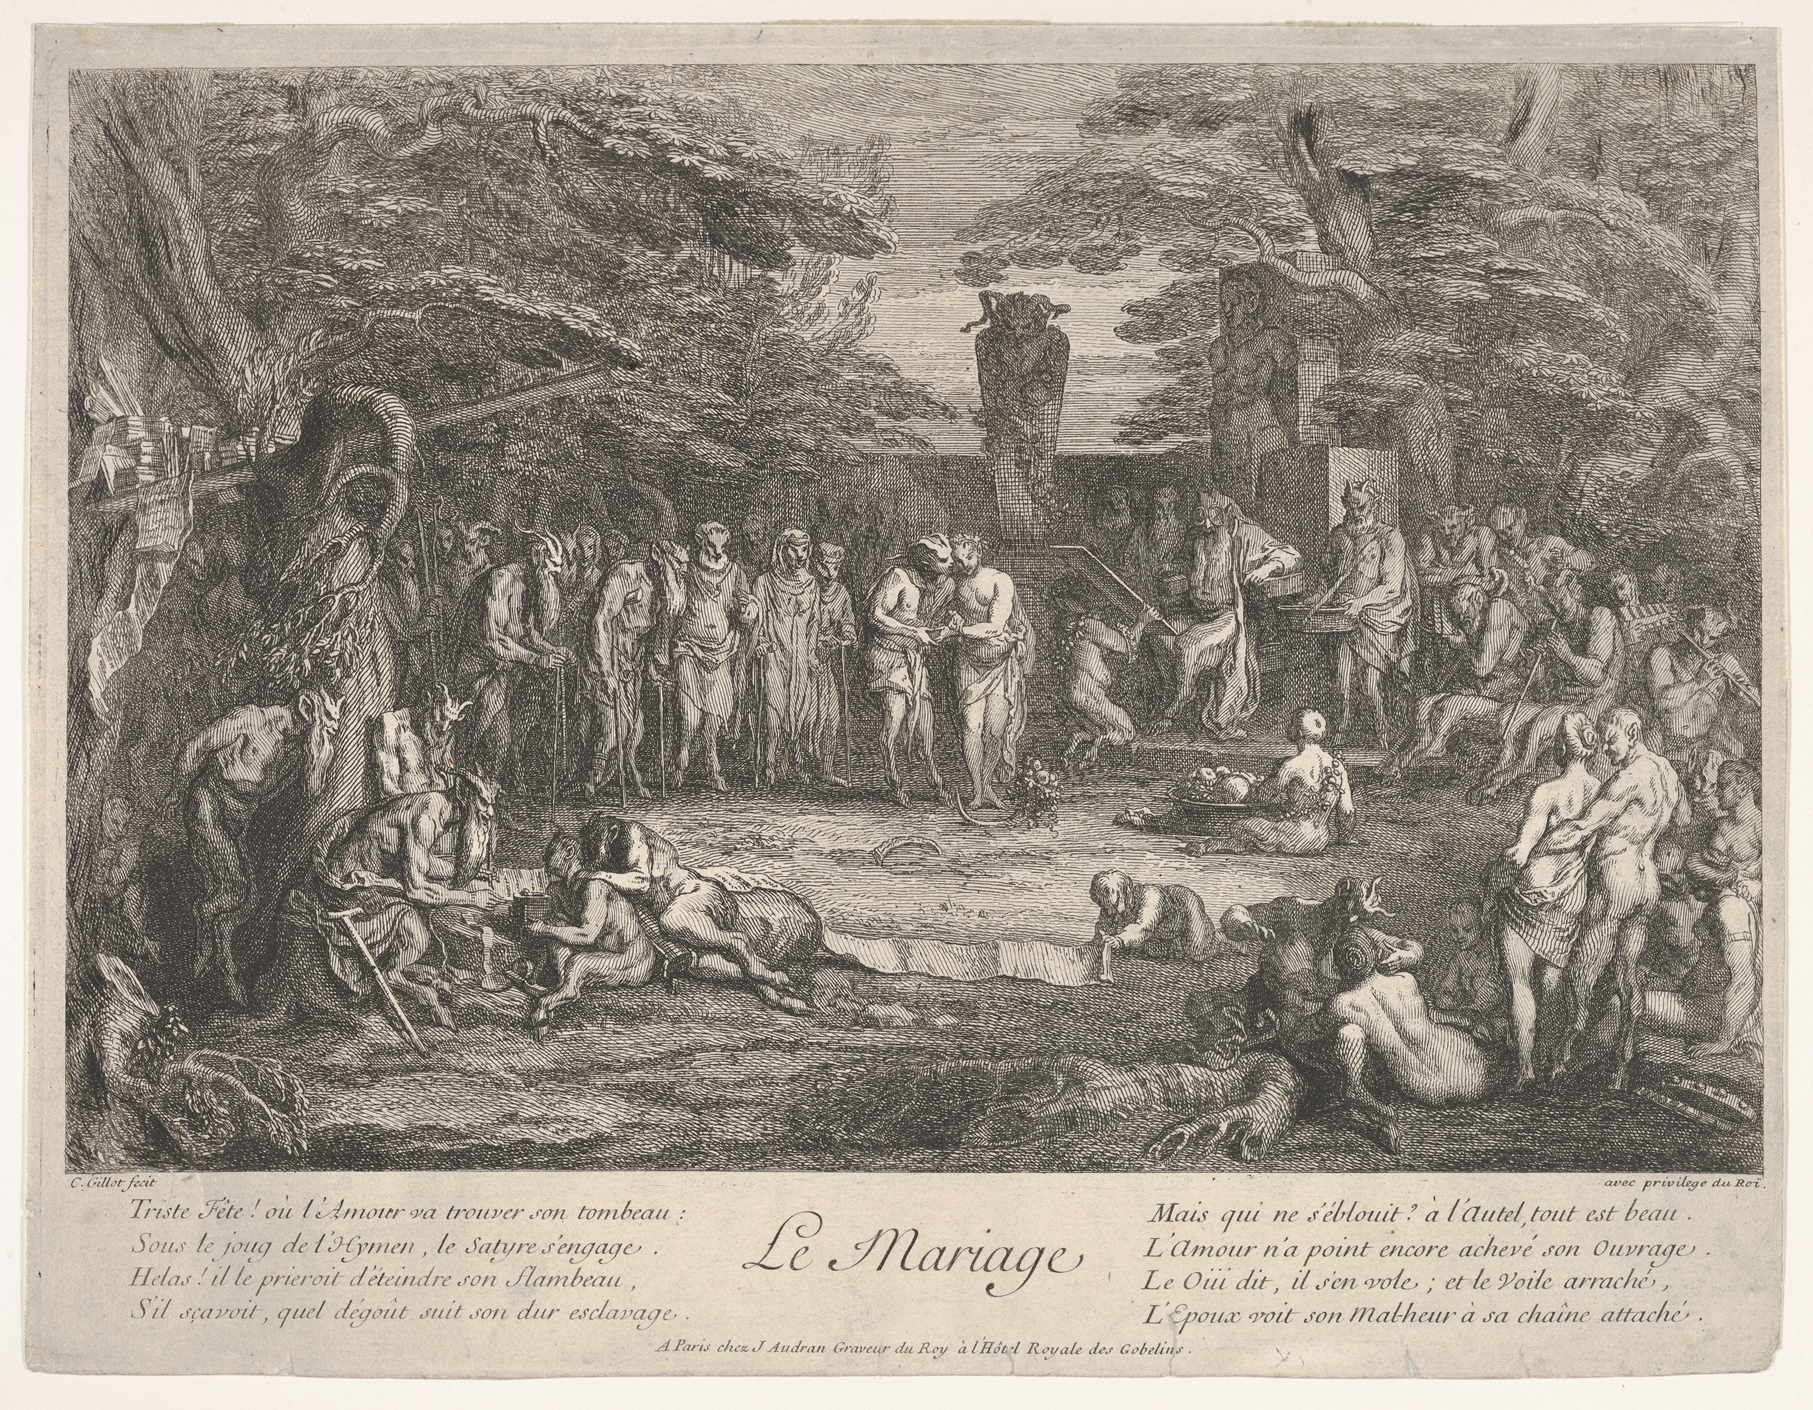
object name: print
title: The Marriage (Le Mariage): in a forest, an old satyr marries the betrothed in center, musicians to right, old satyrs with canes to the left, a couple consulting an old philosopher to left in the foreground, from "The lives of satyrs" (La vie des satyres)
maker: claude gillot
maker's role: artist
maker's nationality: french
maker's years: 1673-1722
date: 1700-1720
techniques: etching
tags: satyrs,forests,musicians